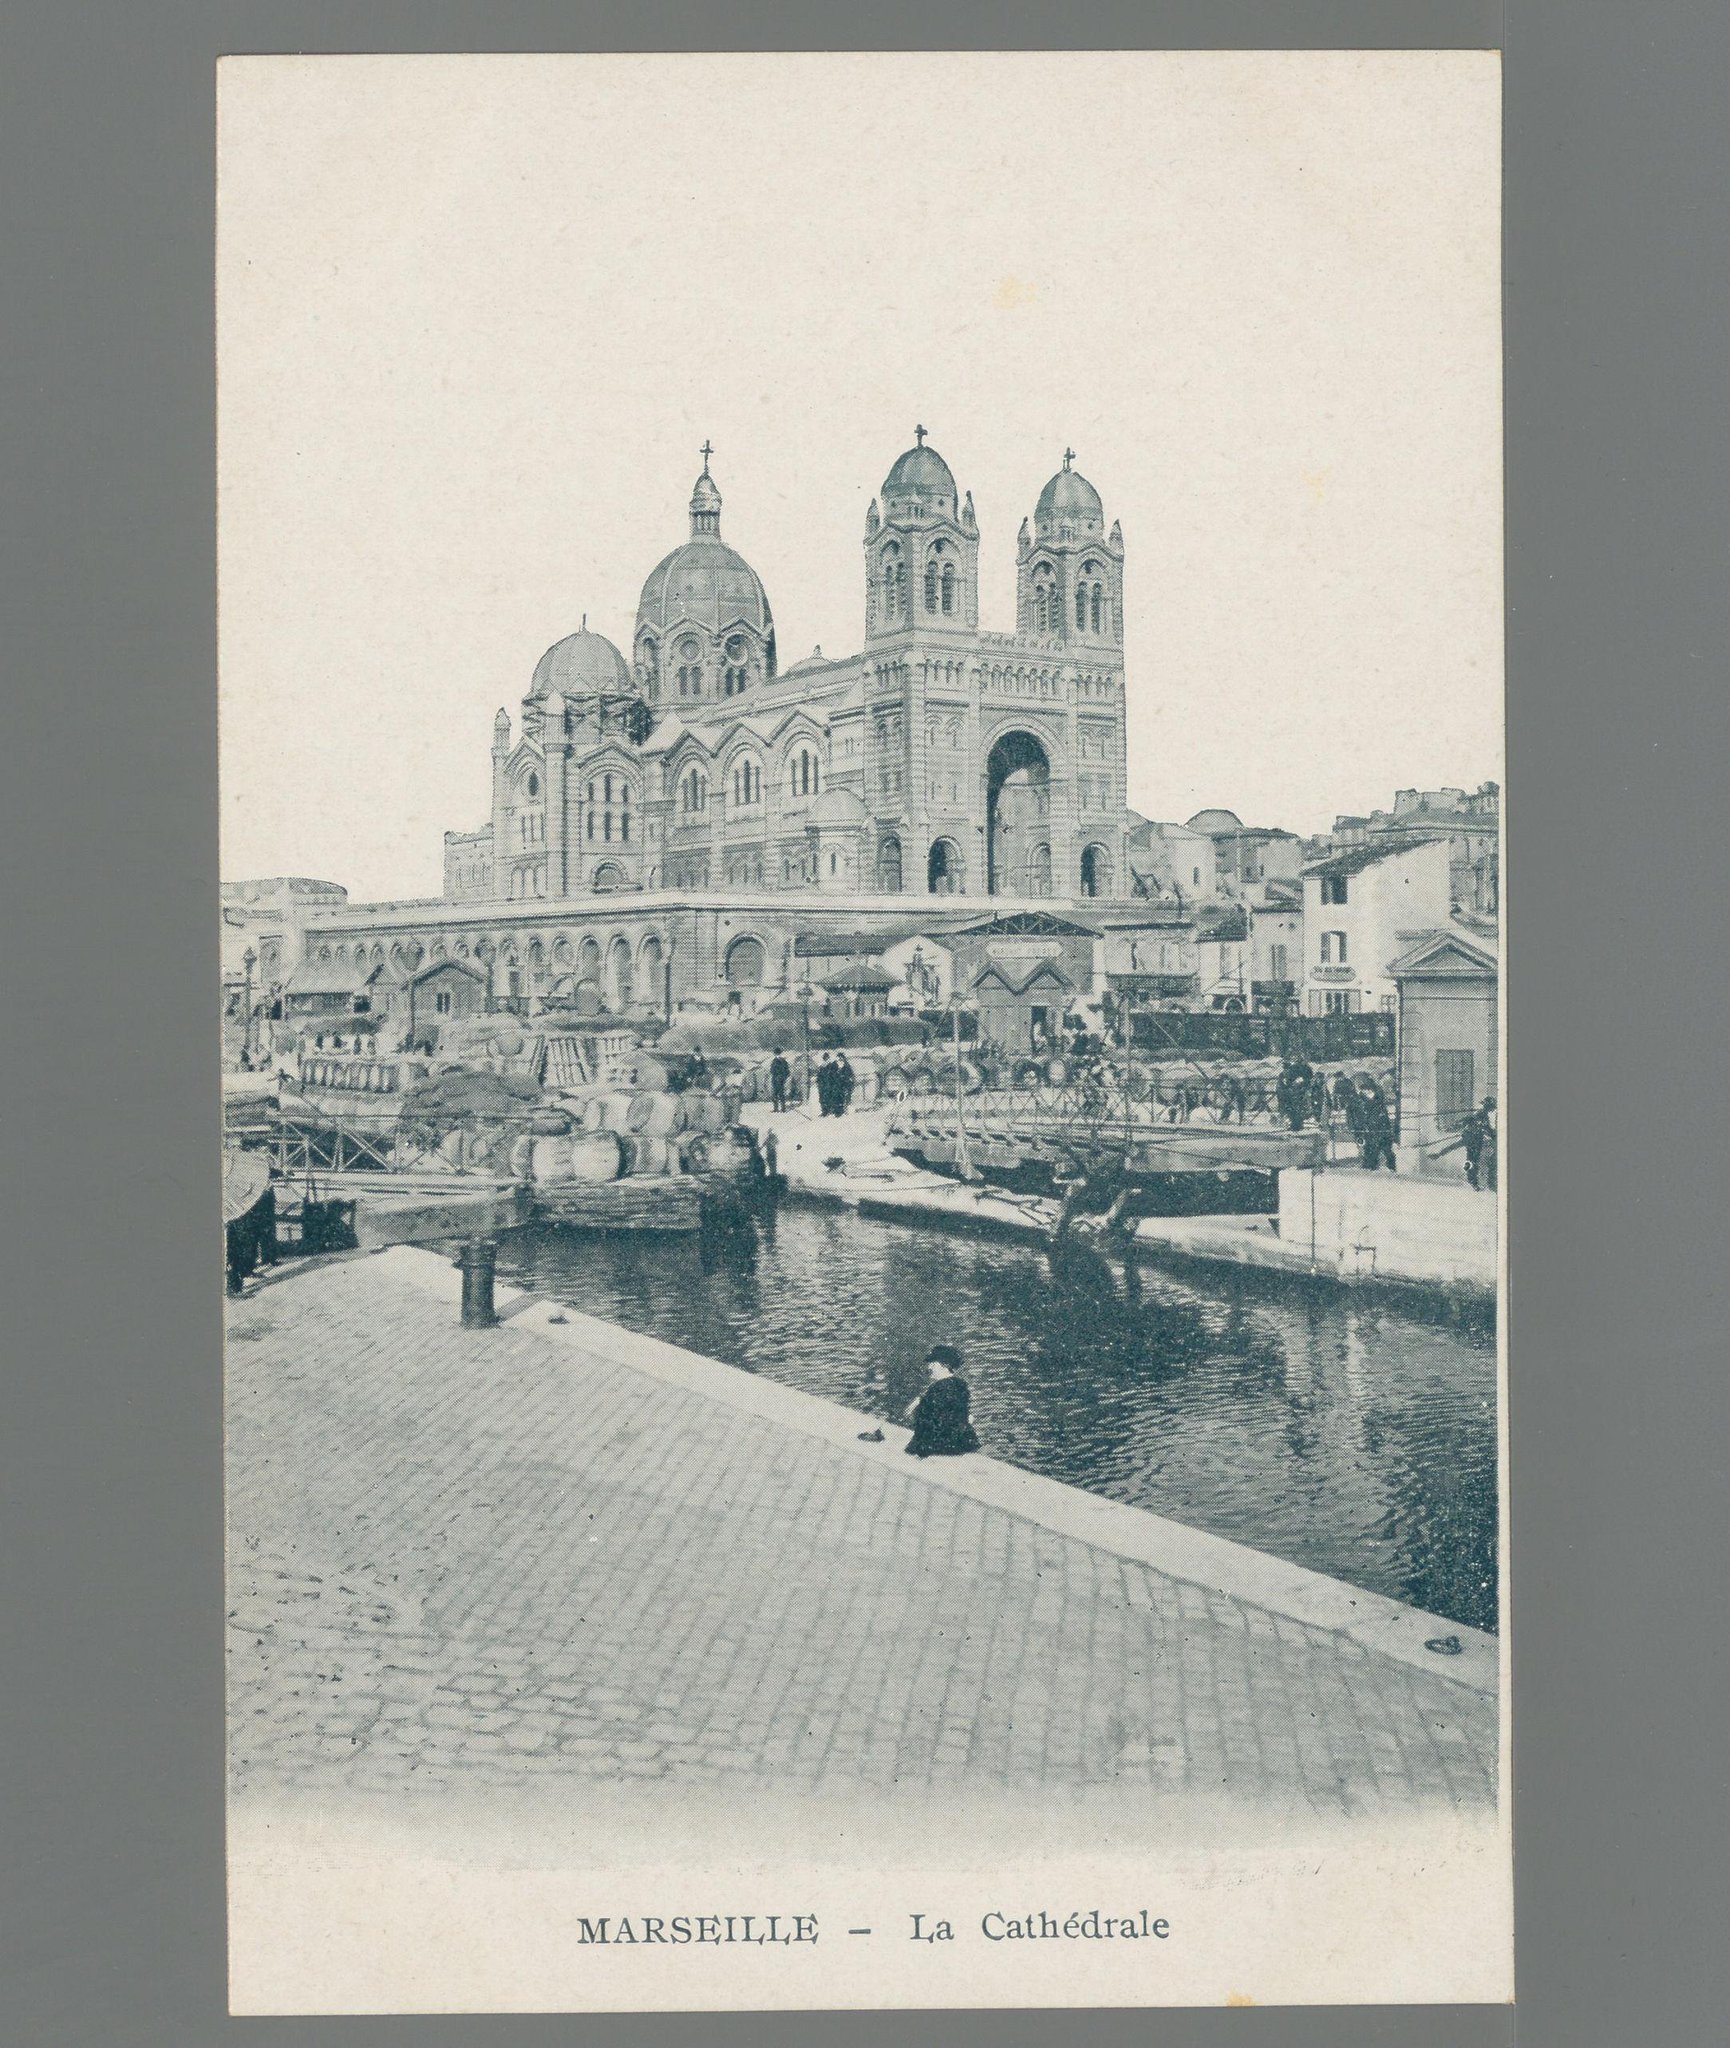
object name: ansichtkaart, prentbriefkaart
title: Marseille. La Cathédrale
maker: Anonymous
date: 1904-1906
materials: cardboard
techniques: autotype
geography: marseille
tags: canal, church (exterior), city-view, and landscape with man-made constructions (+ city(-scape) with figures, staffage), marseille